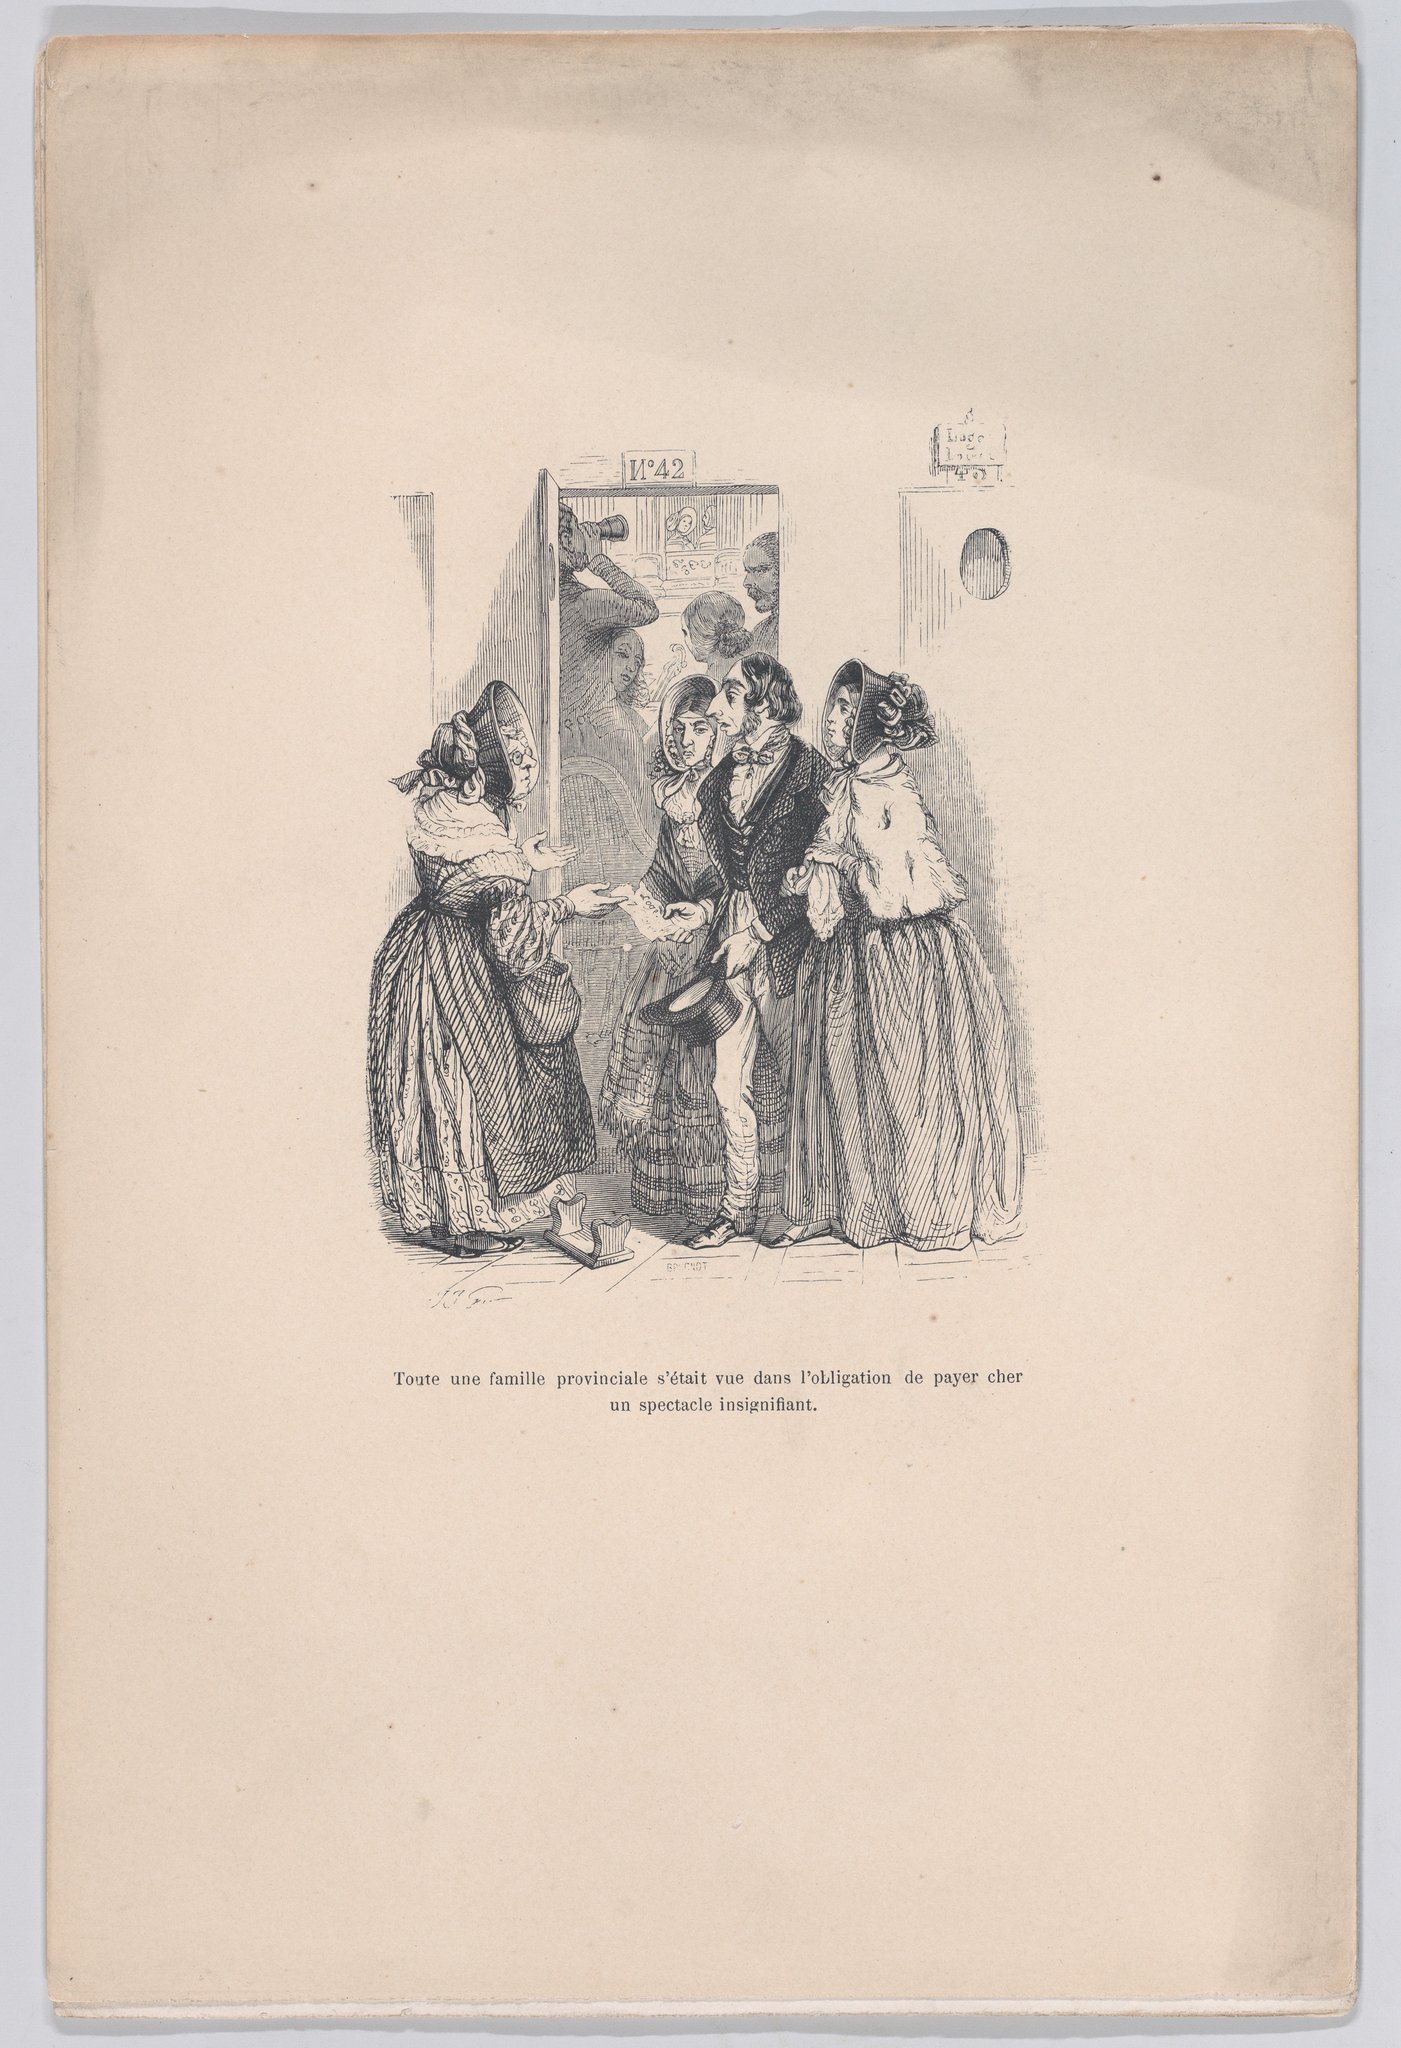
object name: print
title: A provincial family was forced to pay a high price for an insignificant show, from "Little Miseries of Human Life"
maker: j. j. grandville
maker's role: illustrator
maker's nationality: french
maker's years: 1803-1847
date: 1843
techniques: engraving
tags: men,women